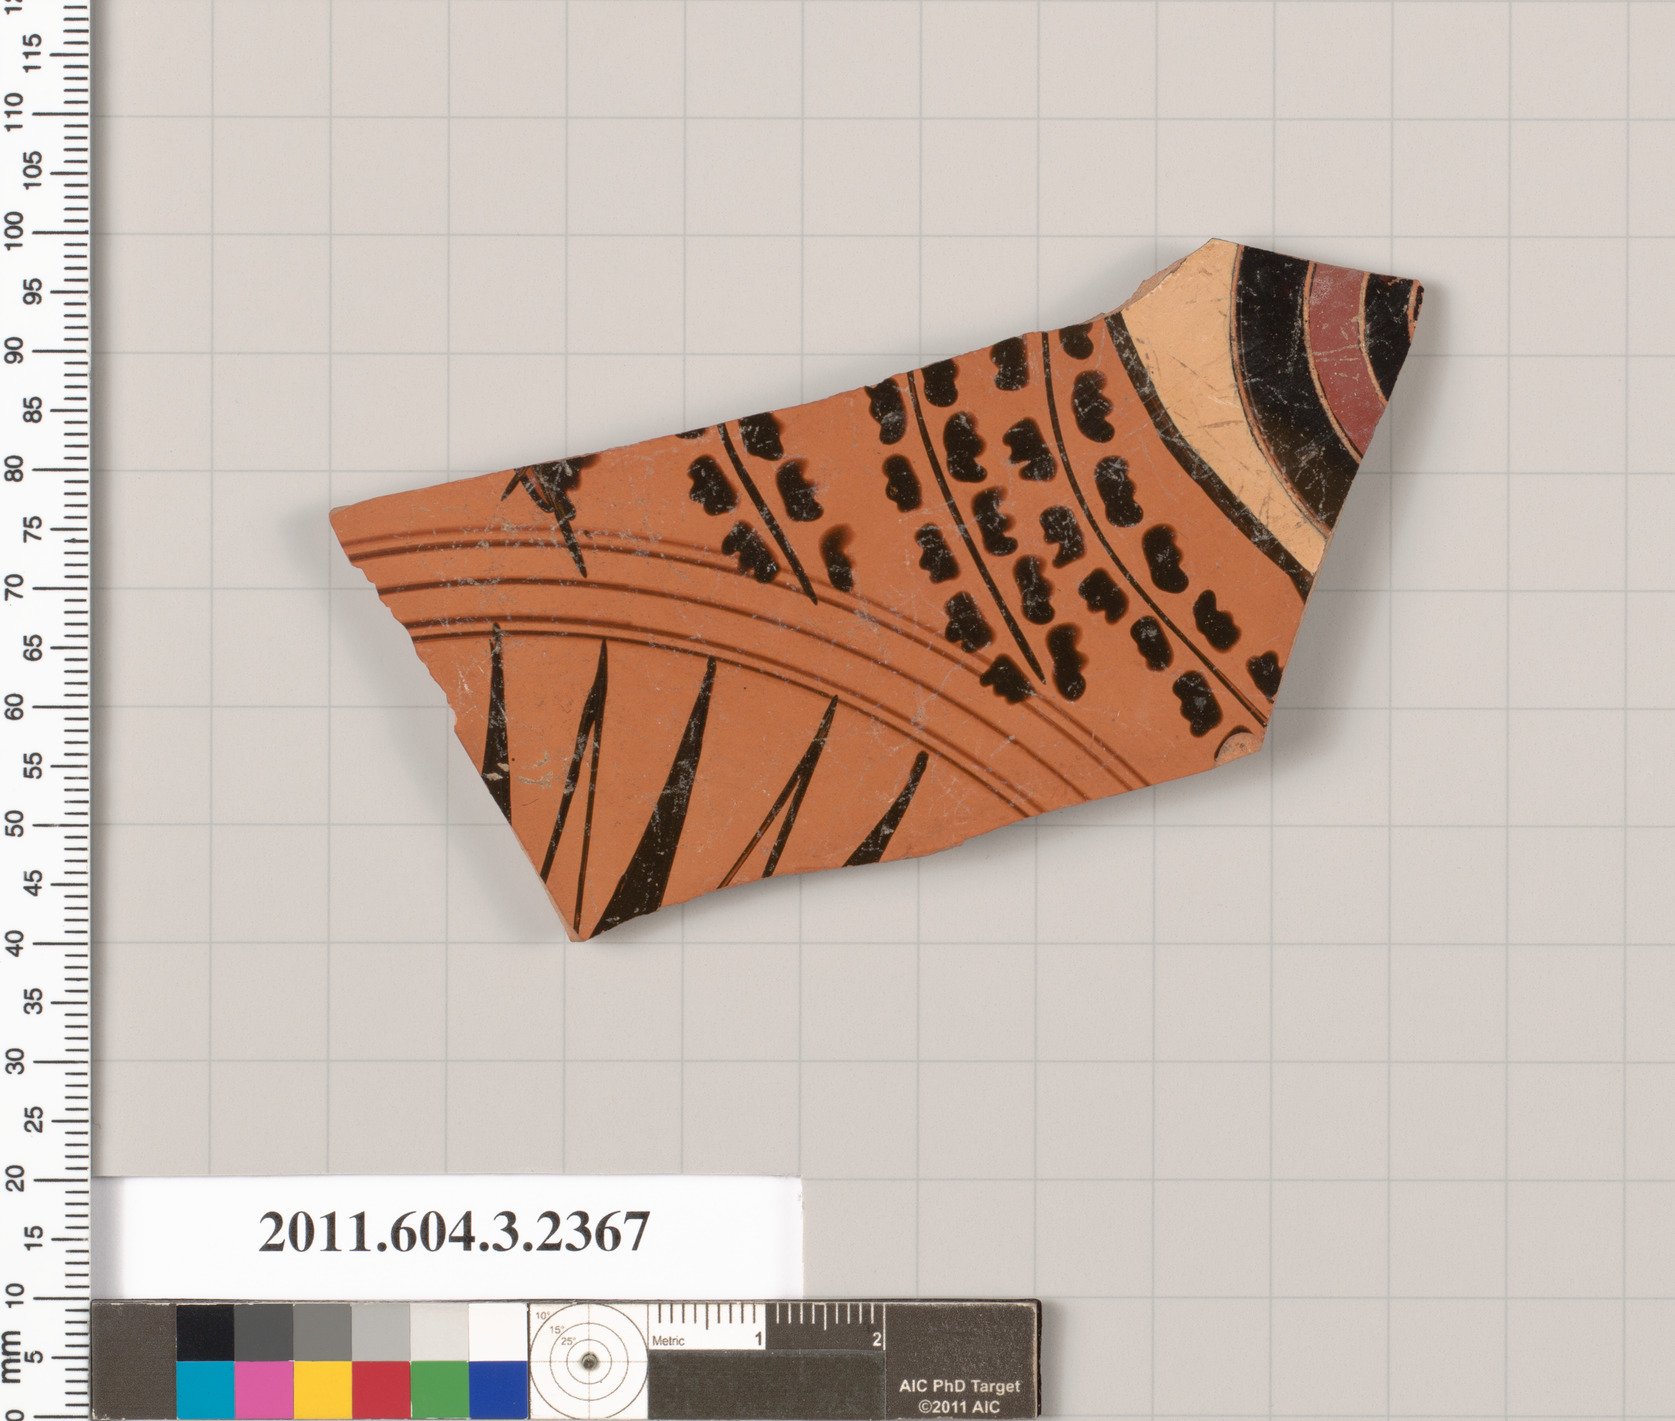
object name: kylix fragment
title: Terracotta fragment of a kylix: eye-cup (drinking cup)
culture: greek, attic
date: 540-520 BCE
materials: terracotta